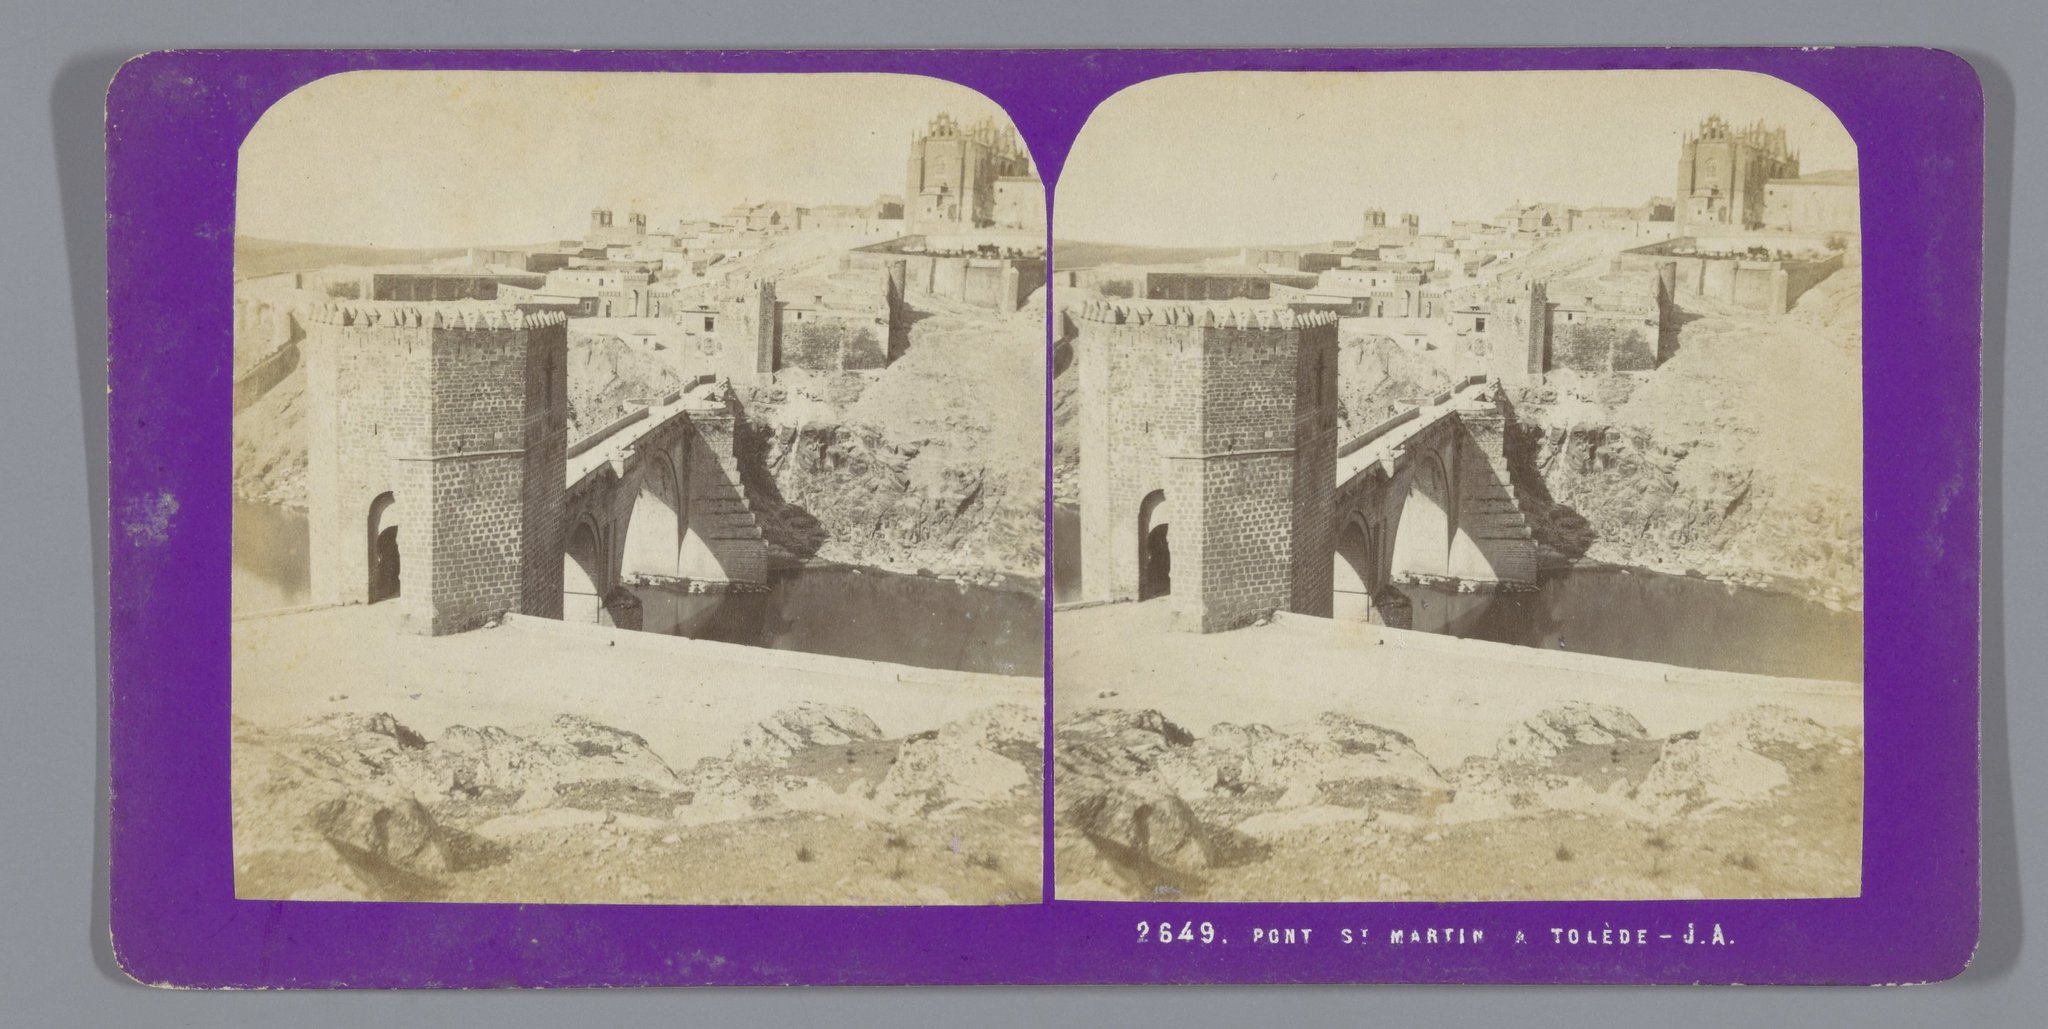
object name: stereograph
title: PONT St MARTIN A TOLÈDE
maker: jean andrieu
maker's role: fotograaf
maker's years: 1816-1872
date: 1862-1876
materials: cardboard, photographic support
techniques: albumen print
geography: toledo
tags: bridge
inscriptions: number: ‘2649.’